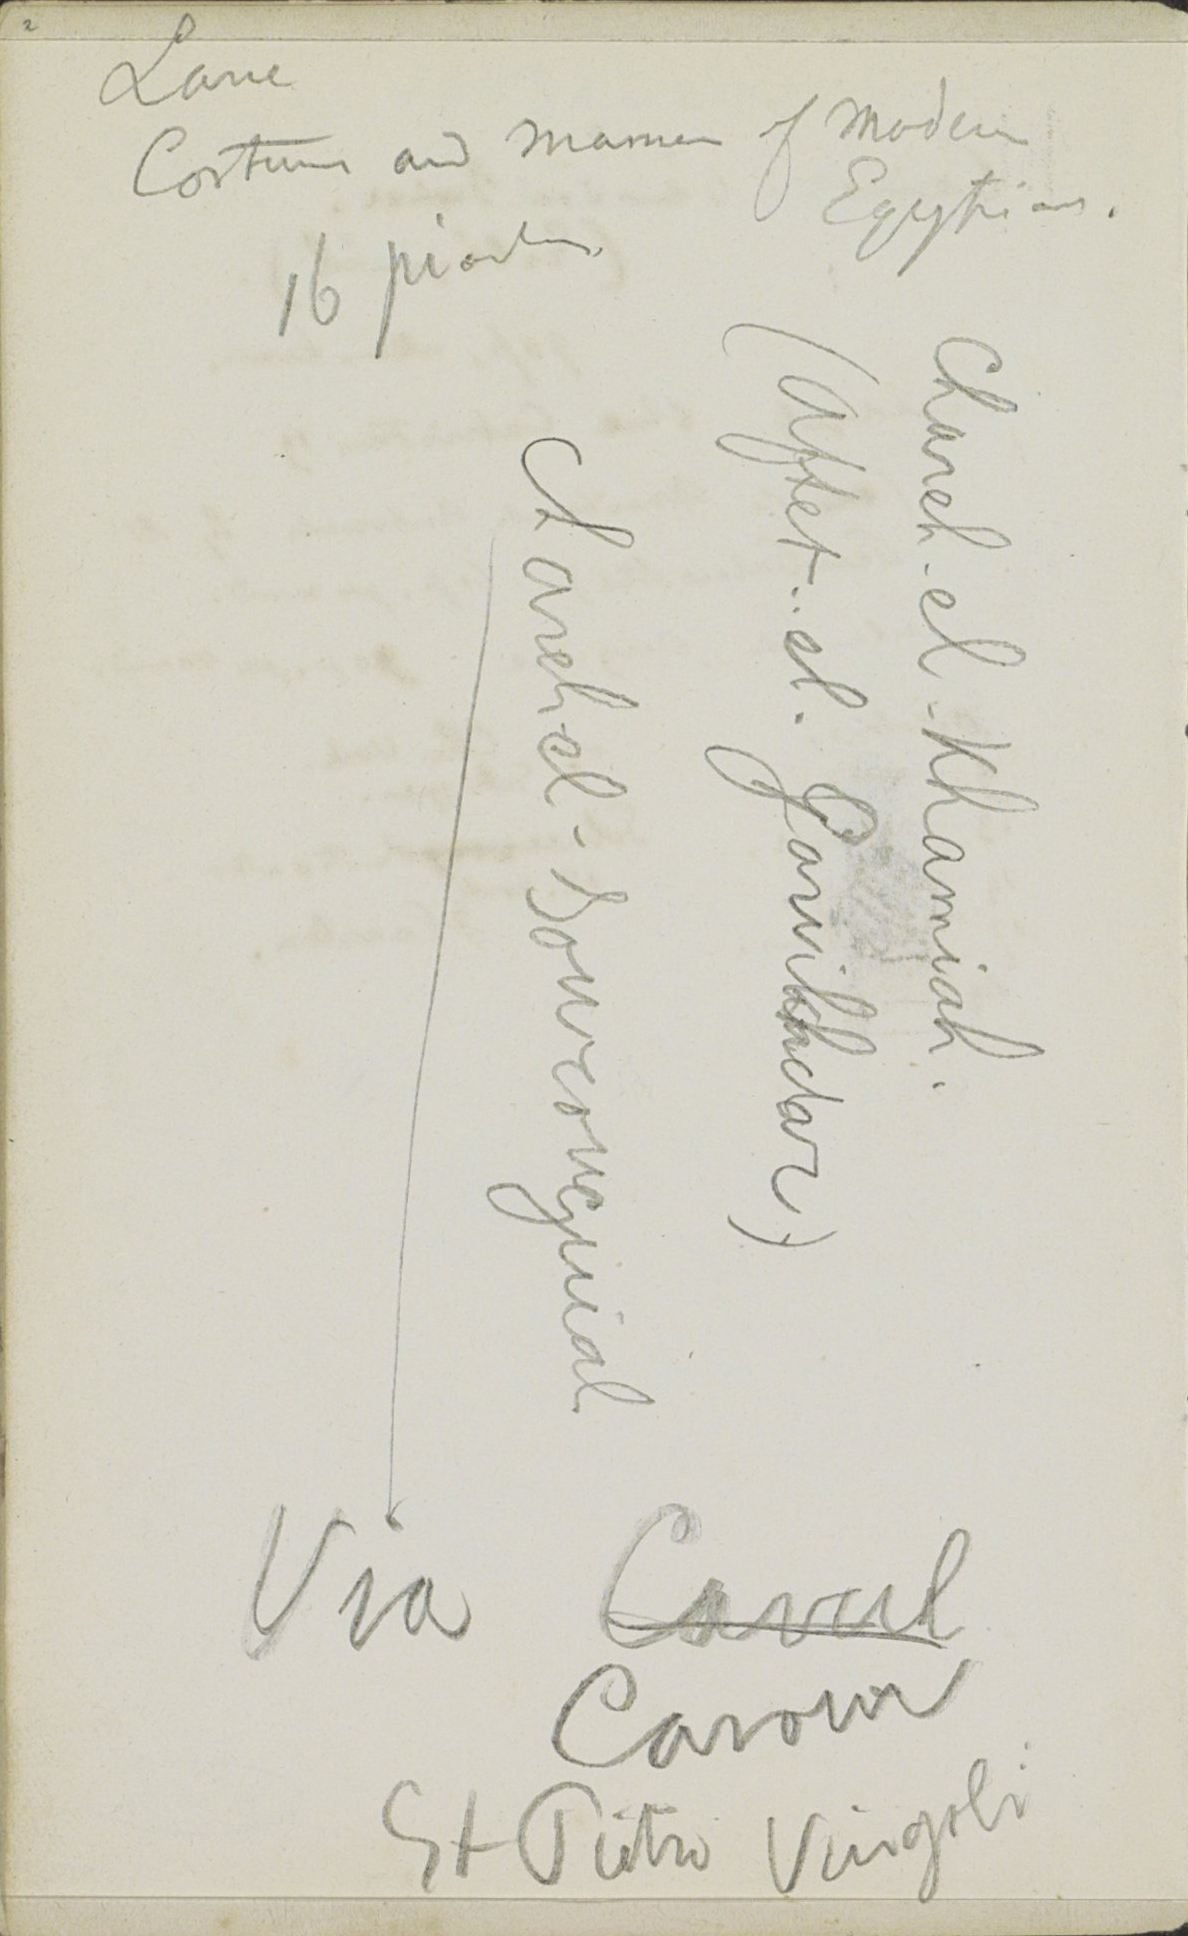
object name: sketchbook leaf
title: Reisnotities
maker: marius bauer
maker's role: draughtsman, print maker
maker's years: 1867-1932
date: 1904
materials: paper, pencil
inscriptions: annotation: ‘Lane/ Costums and manners of modern/ Egyptians. [...] Chareh-el-khamiah./ (affet.el.Ga[...]ikhdar) [...]’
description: Pagina 2 uit een schetsboek met 56 bladen.